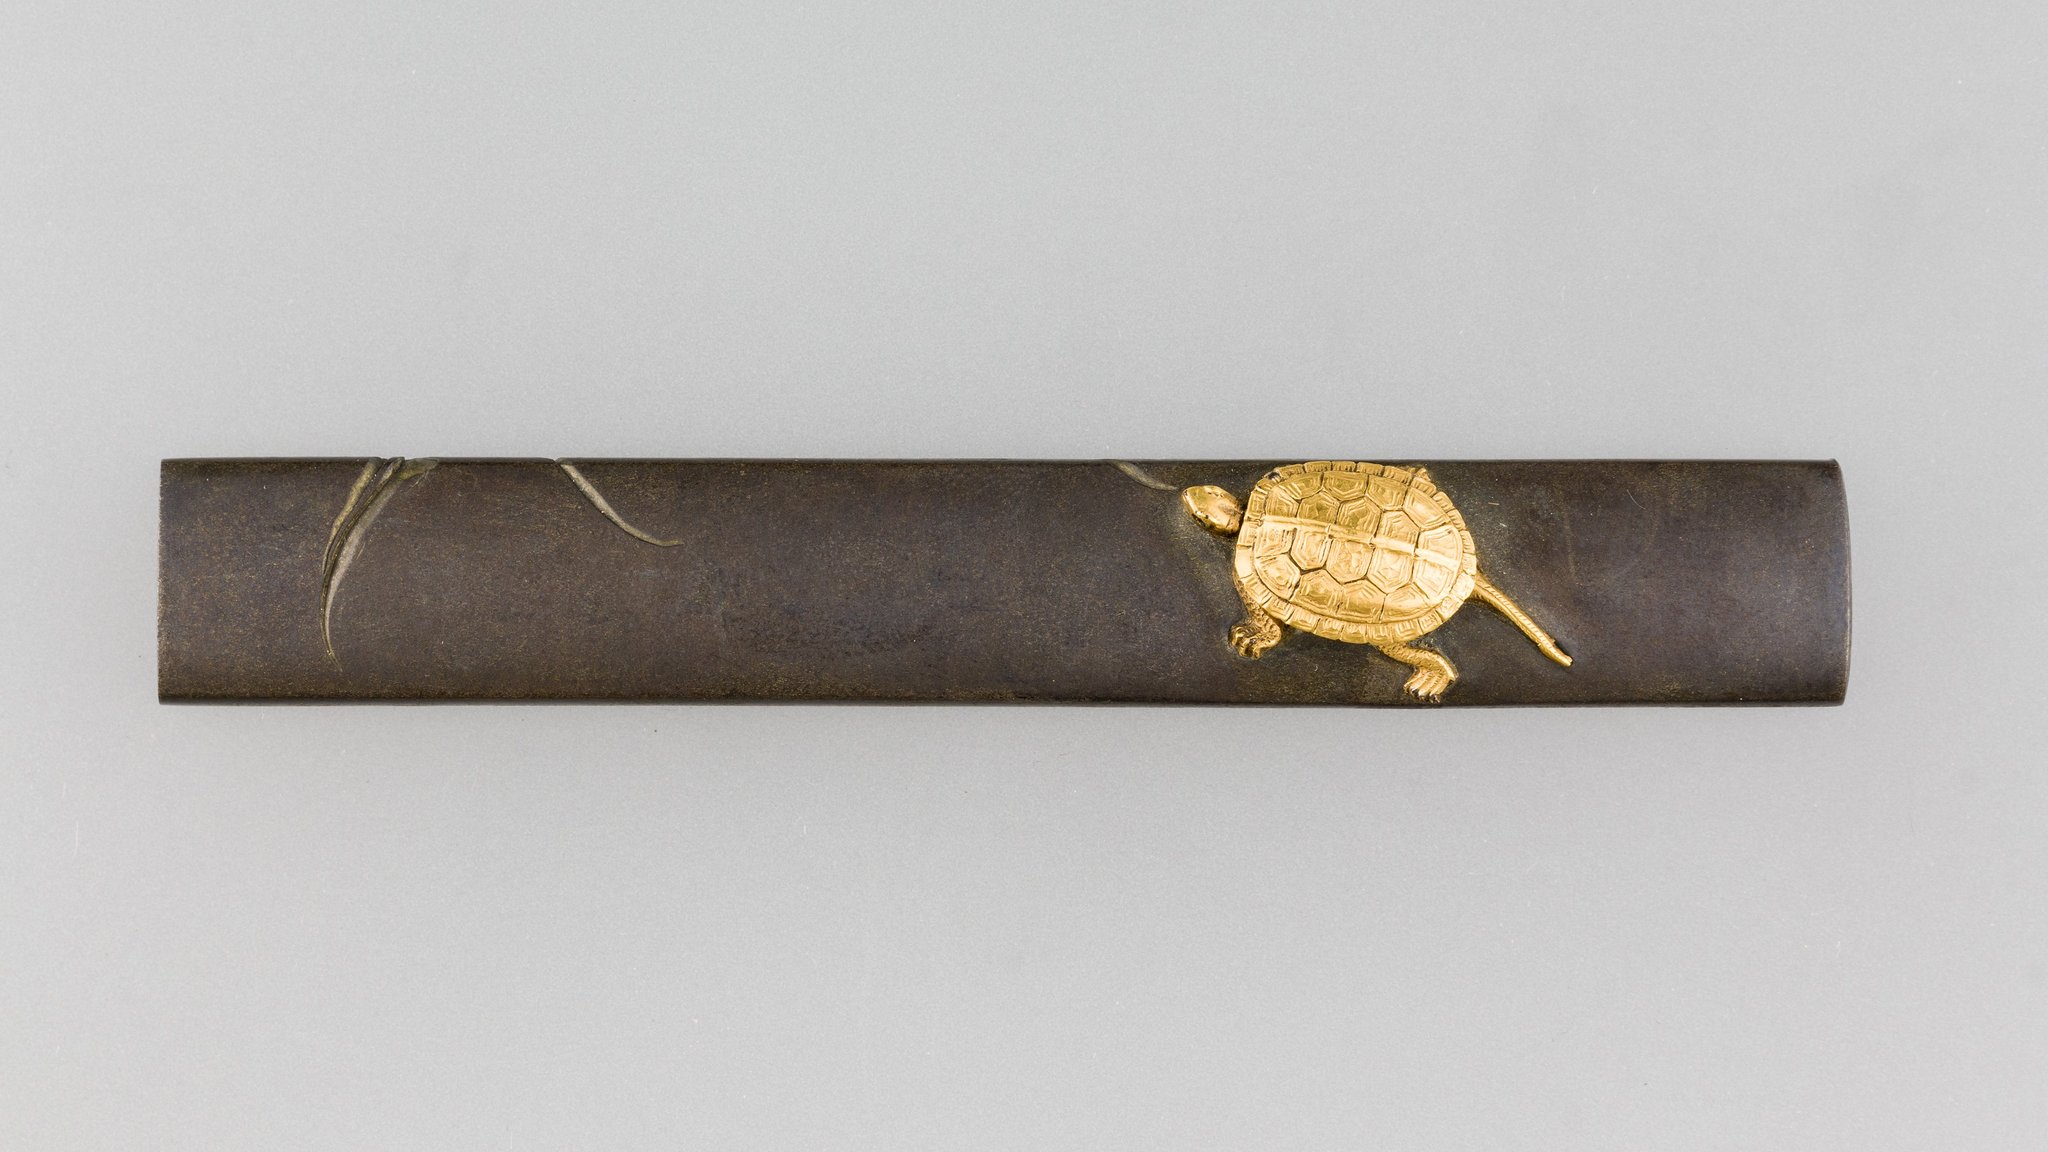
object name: knife handle kozuka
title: Knife Handle (Kozuka)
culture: japanese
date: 1801-1833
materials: gold alloy, silver alloy, gold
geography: japan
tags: turtles